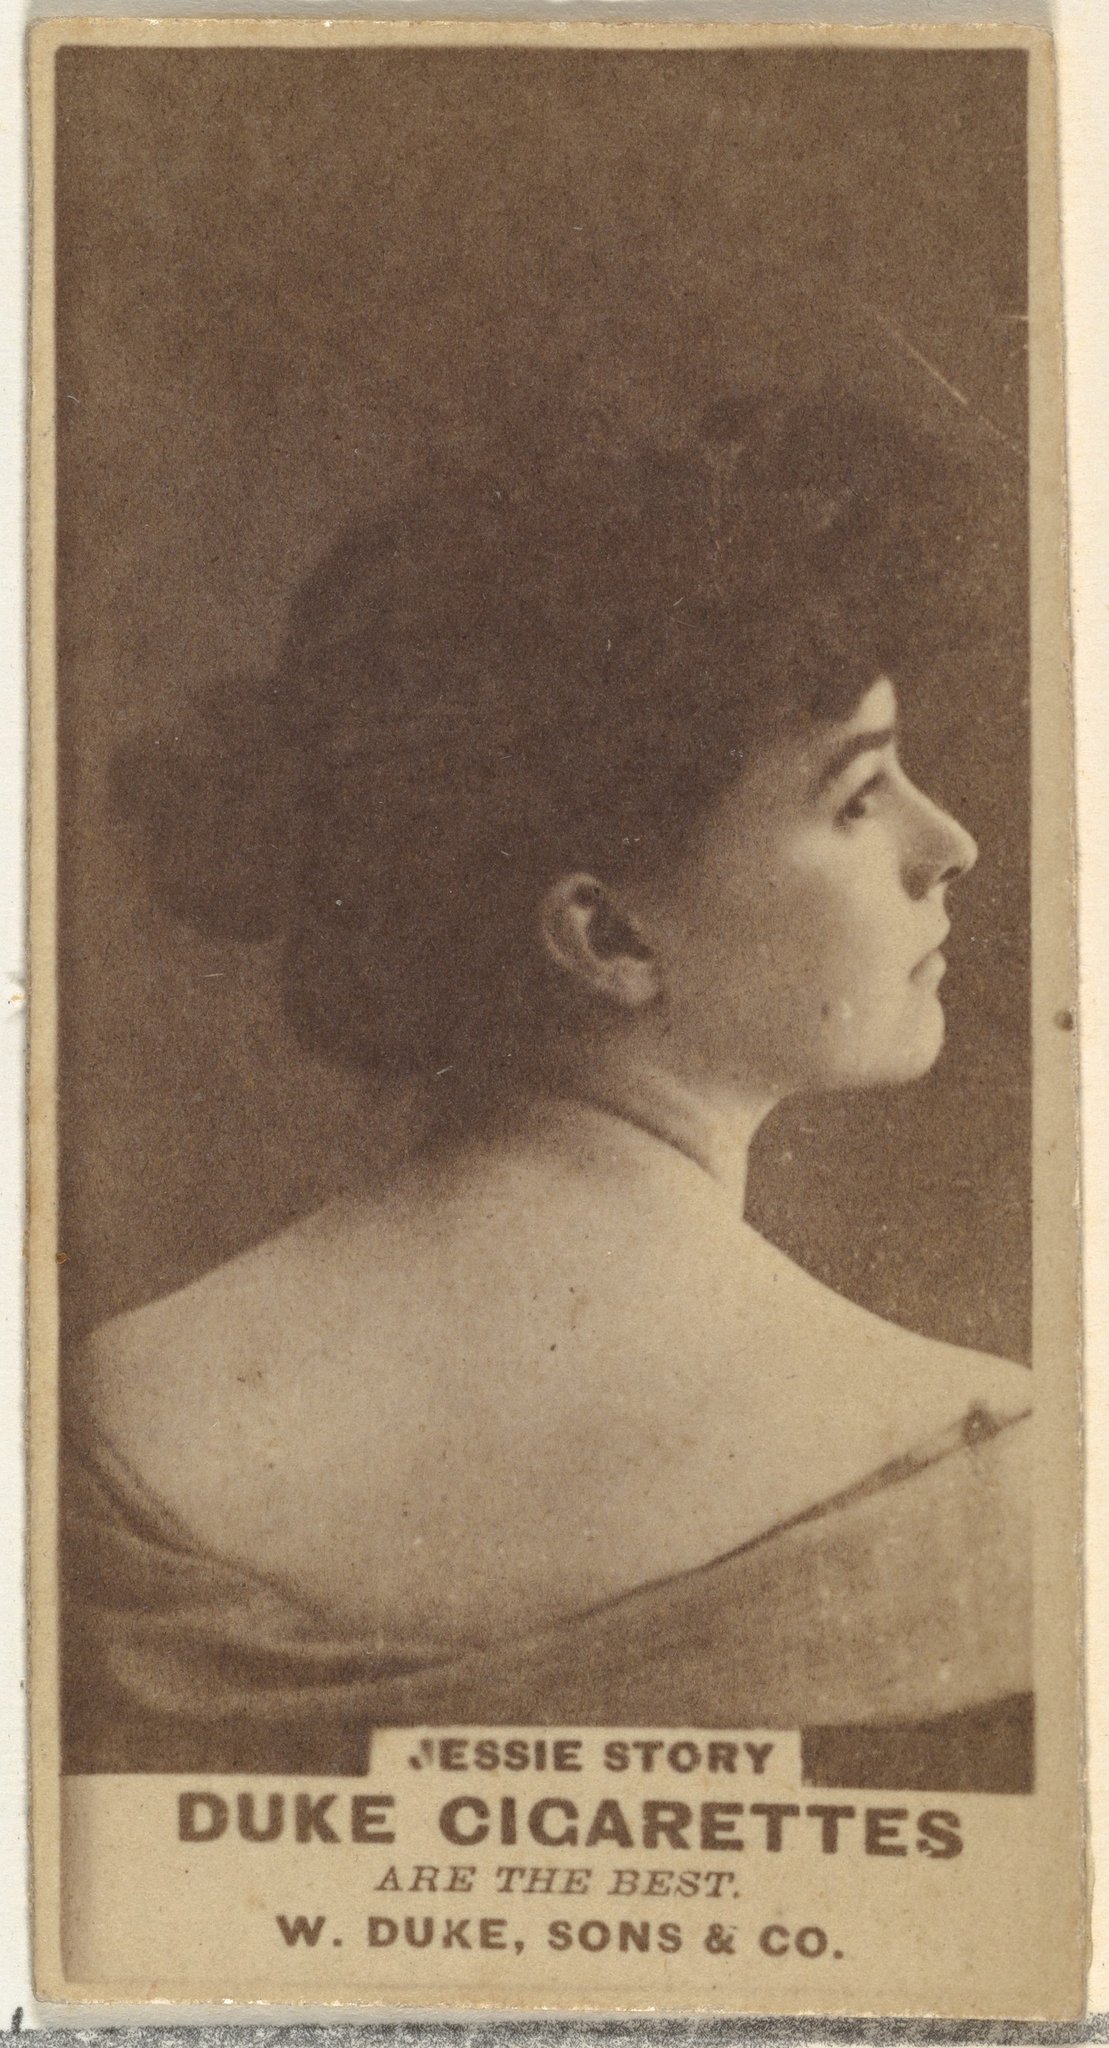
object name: photograph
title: Jessie Story, from the Actors and Actresses series (N145-7) issued by Duke Sons & Co. to promote Duke Cigarettes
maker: w. duke, sons & co.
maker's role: publisher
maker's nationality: american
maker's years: 1870-1920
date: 1880-1889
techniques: albumen silver print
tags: women,actresses